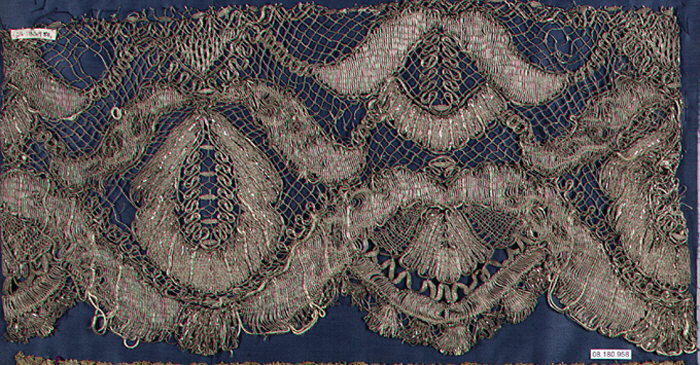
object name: strip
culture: mexican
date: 1501-1600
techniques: lace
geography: mexico